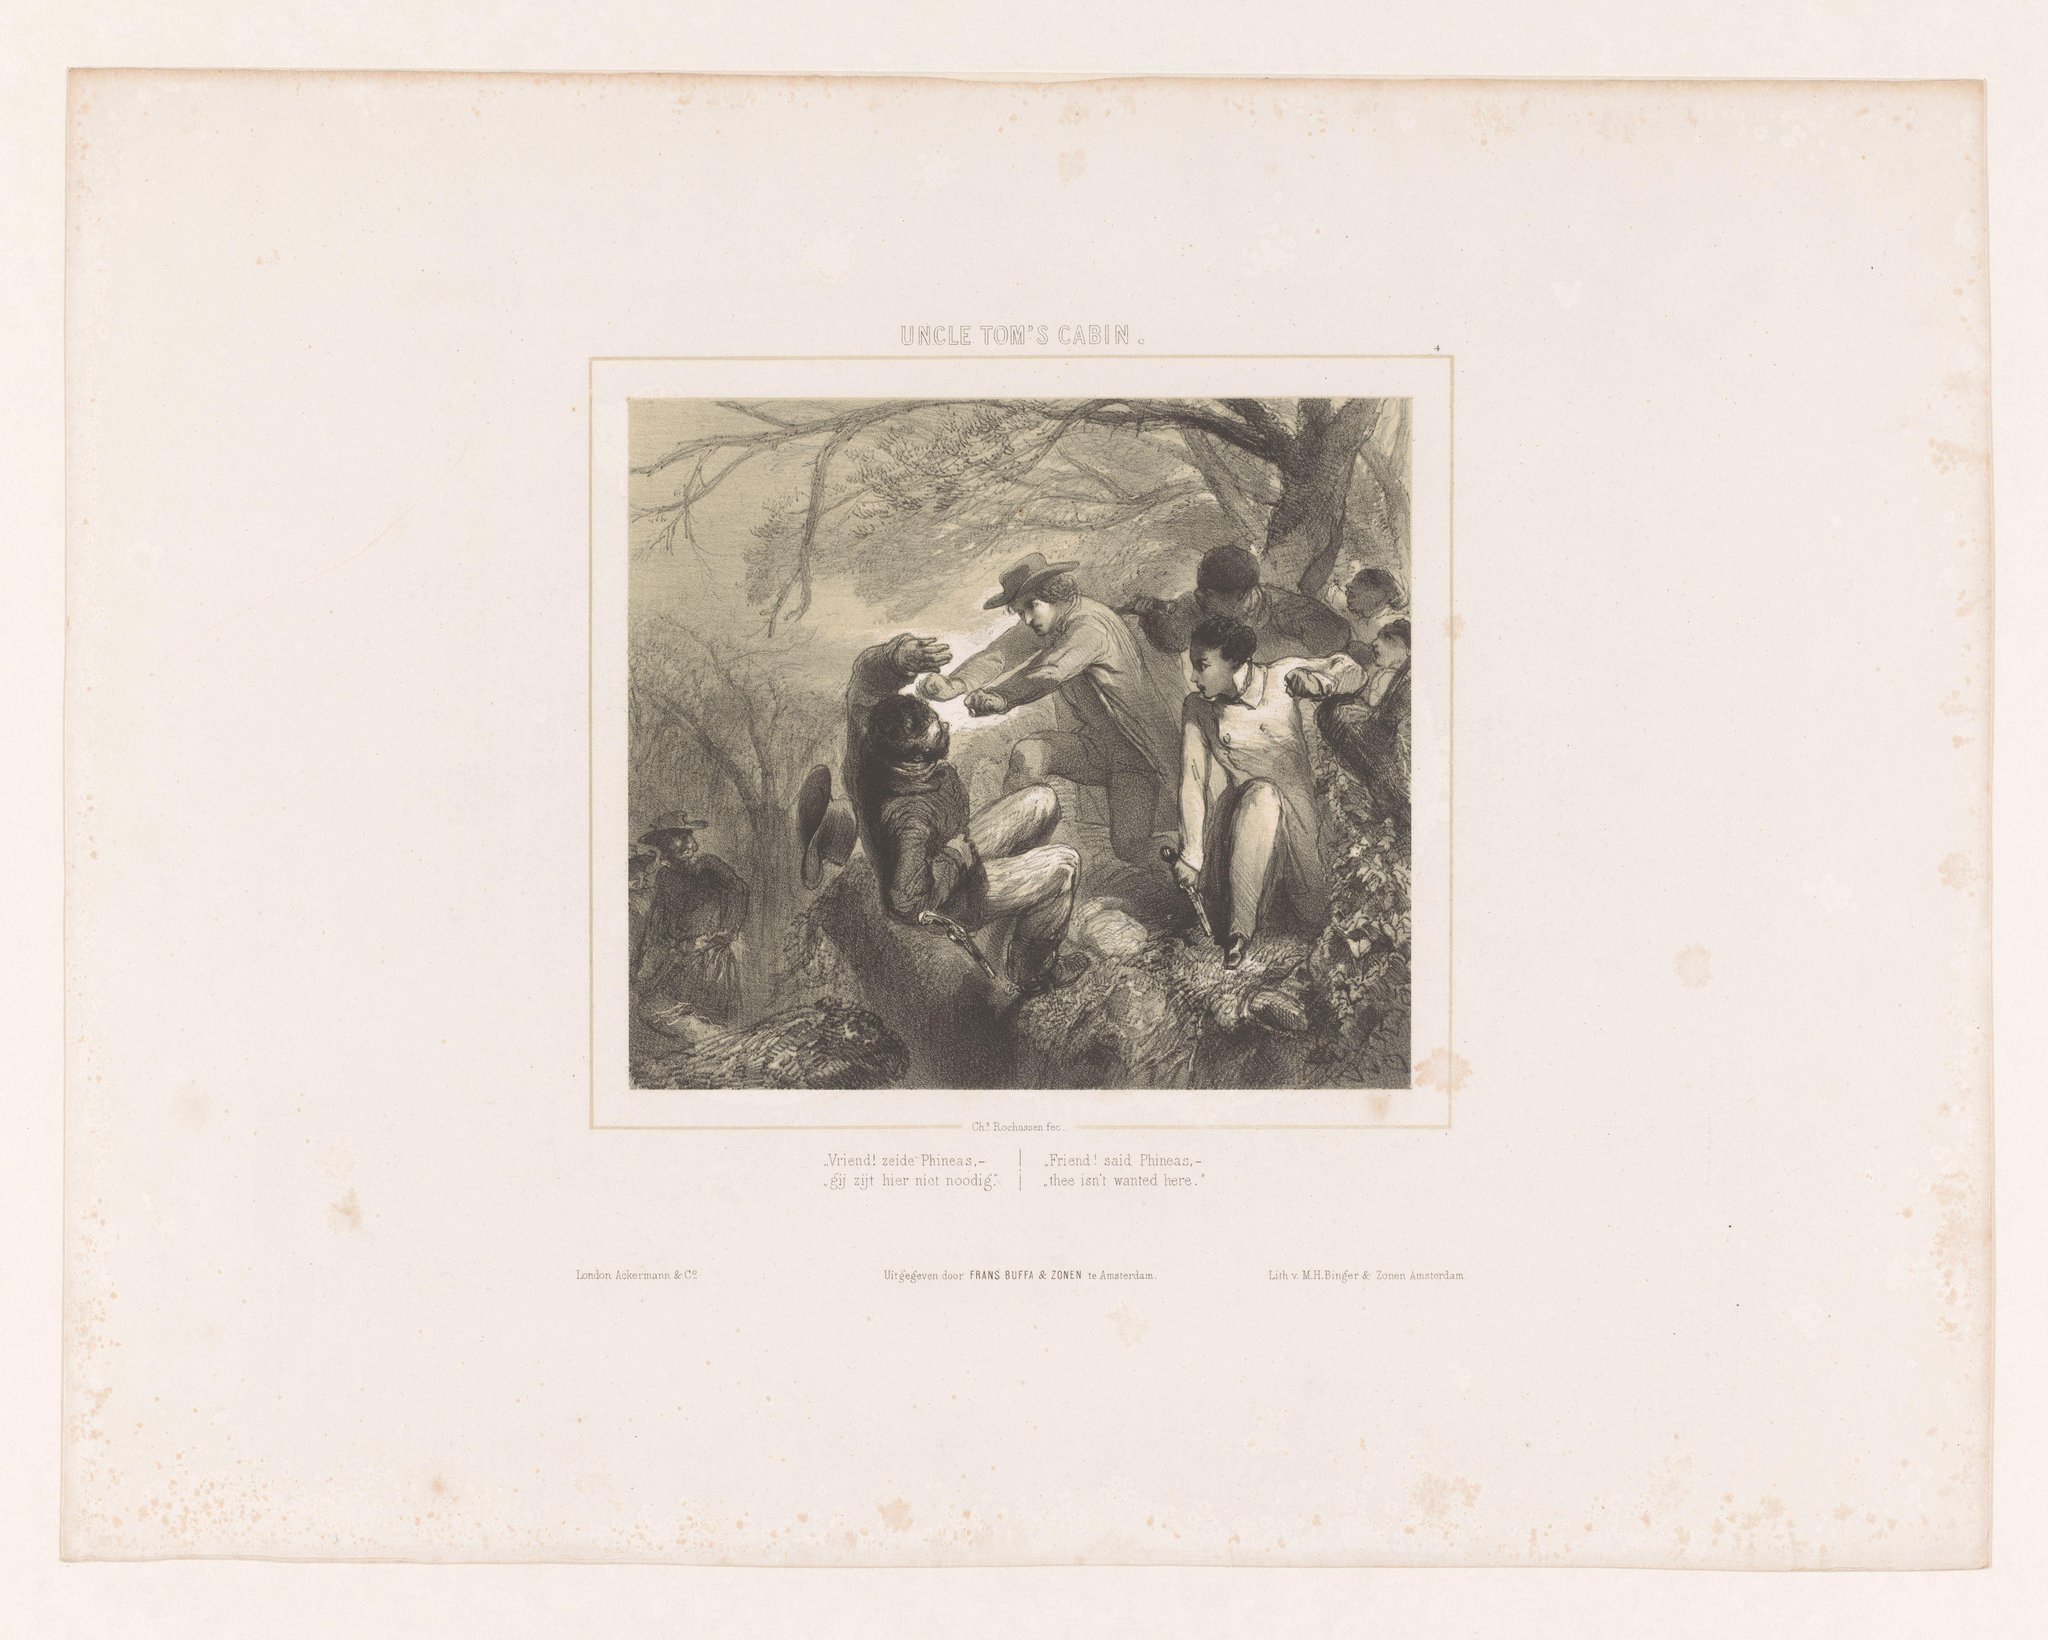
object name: print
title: Uncle Tom's cabin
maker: charles rochussen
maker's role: draughtsman, painter, print maker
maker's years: 1814-1894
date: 1850-1856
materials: paper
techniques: tone lithography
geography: london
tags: master ~ enslaved person, slave-trade, slavery; serfs and enslaved persons, pushing something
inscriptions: collector's mark: Lugt 2228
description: Quaker Phineas duwt slavenhandelaar Tom Loker van een berg.